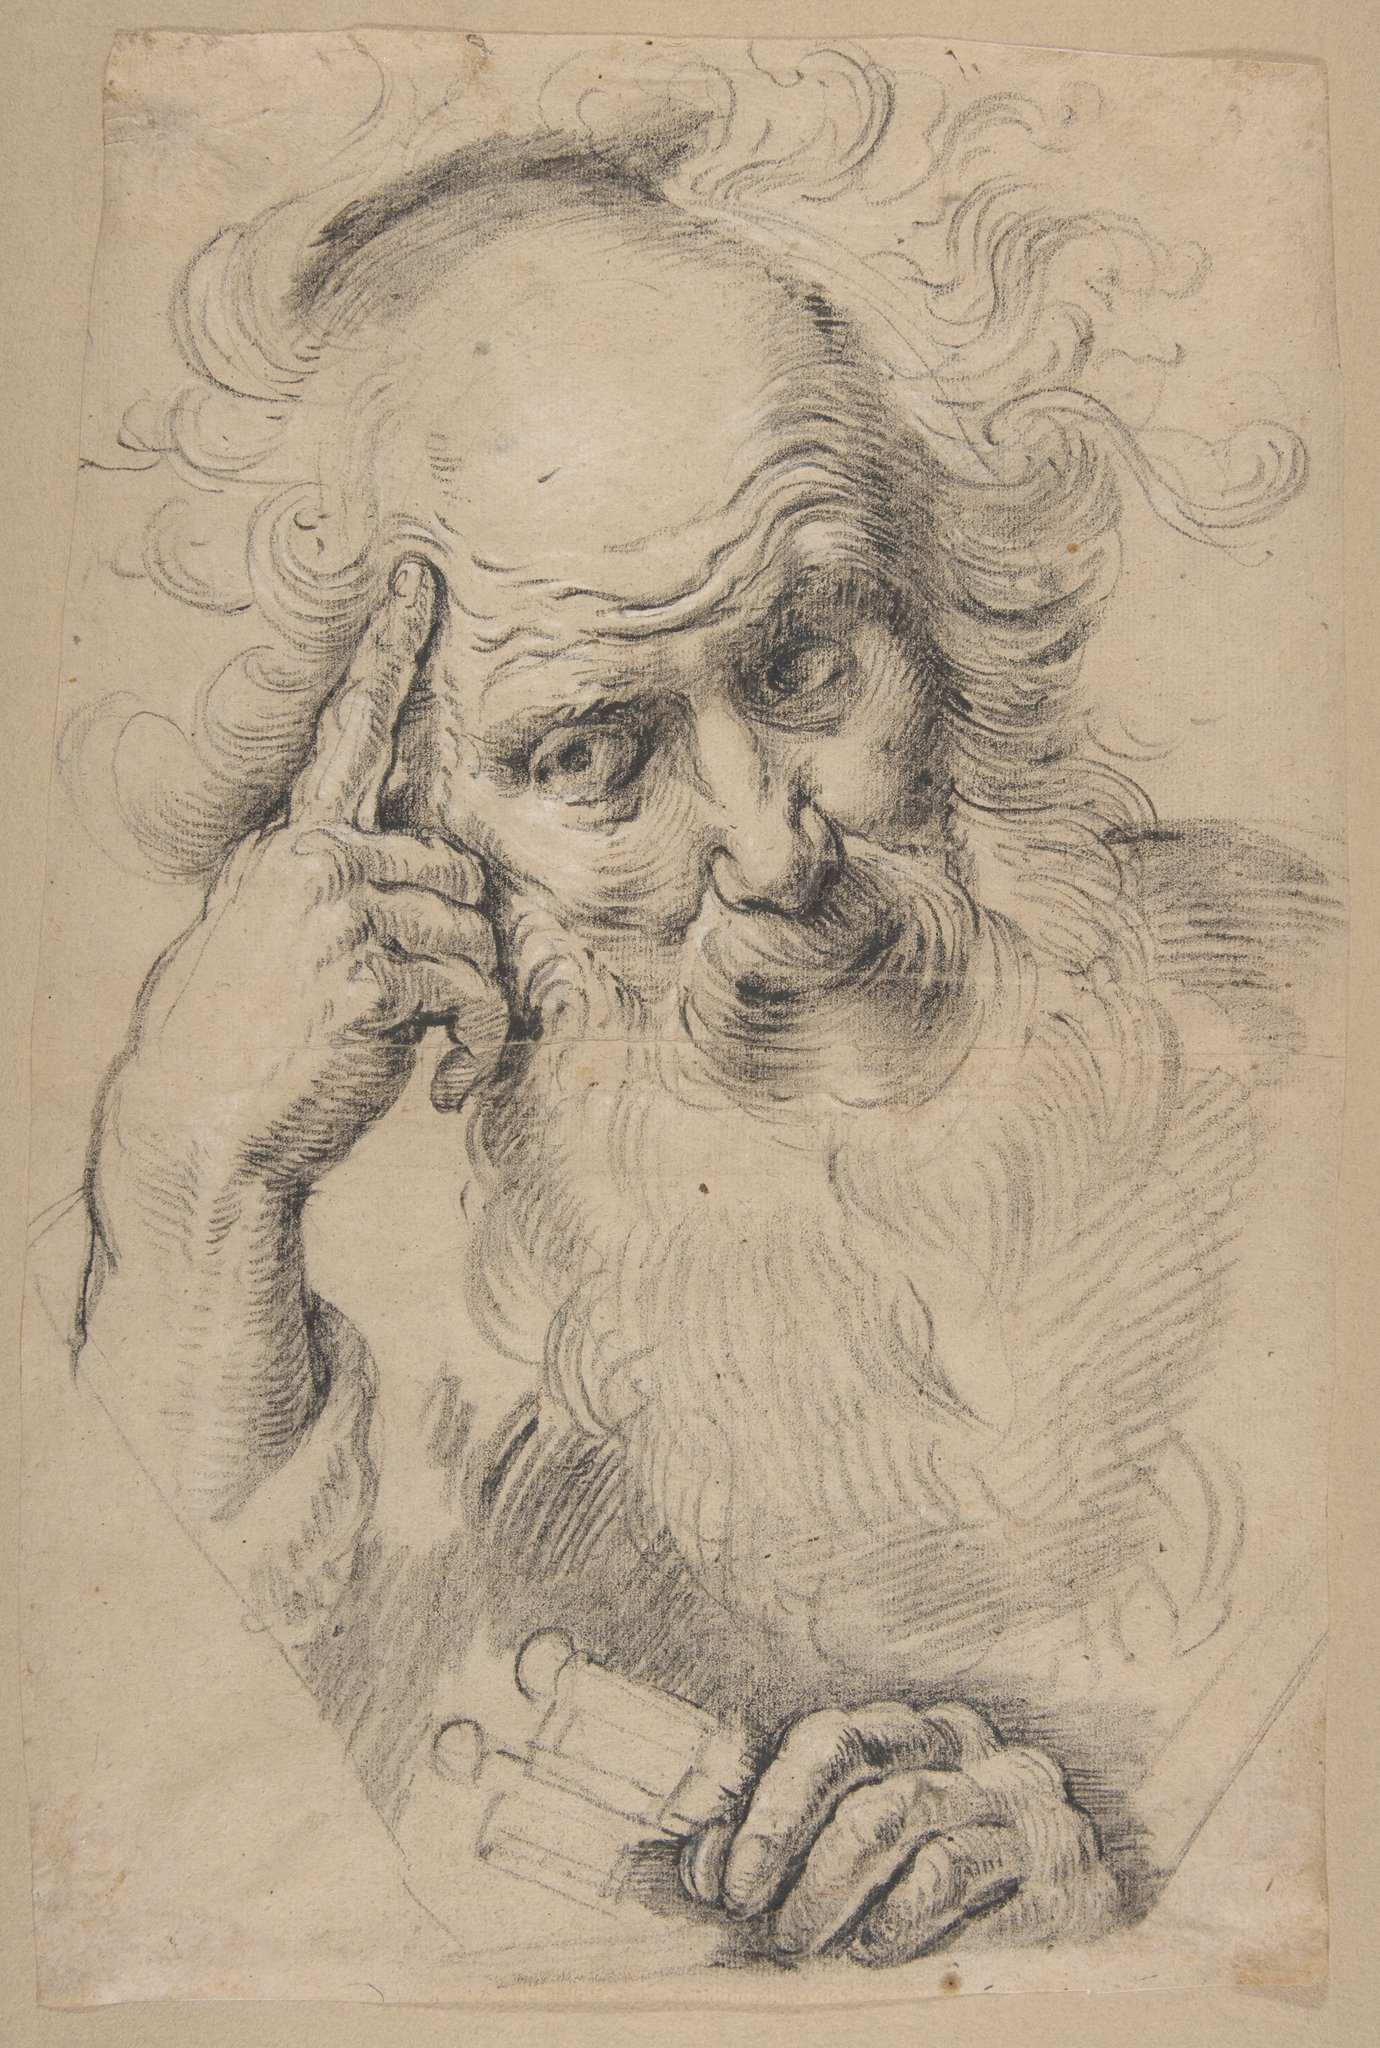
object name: drawing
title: Saint Peter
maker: bernardo strozzi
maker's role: artist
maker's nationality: italian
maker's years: 1581-1644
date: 1581-1644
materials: chalk, paper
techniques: highlighting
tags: contemplation,saint peter